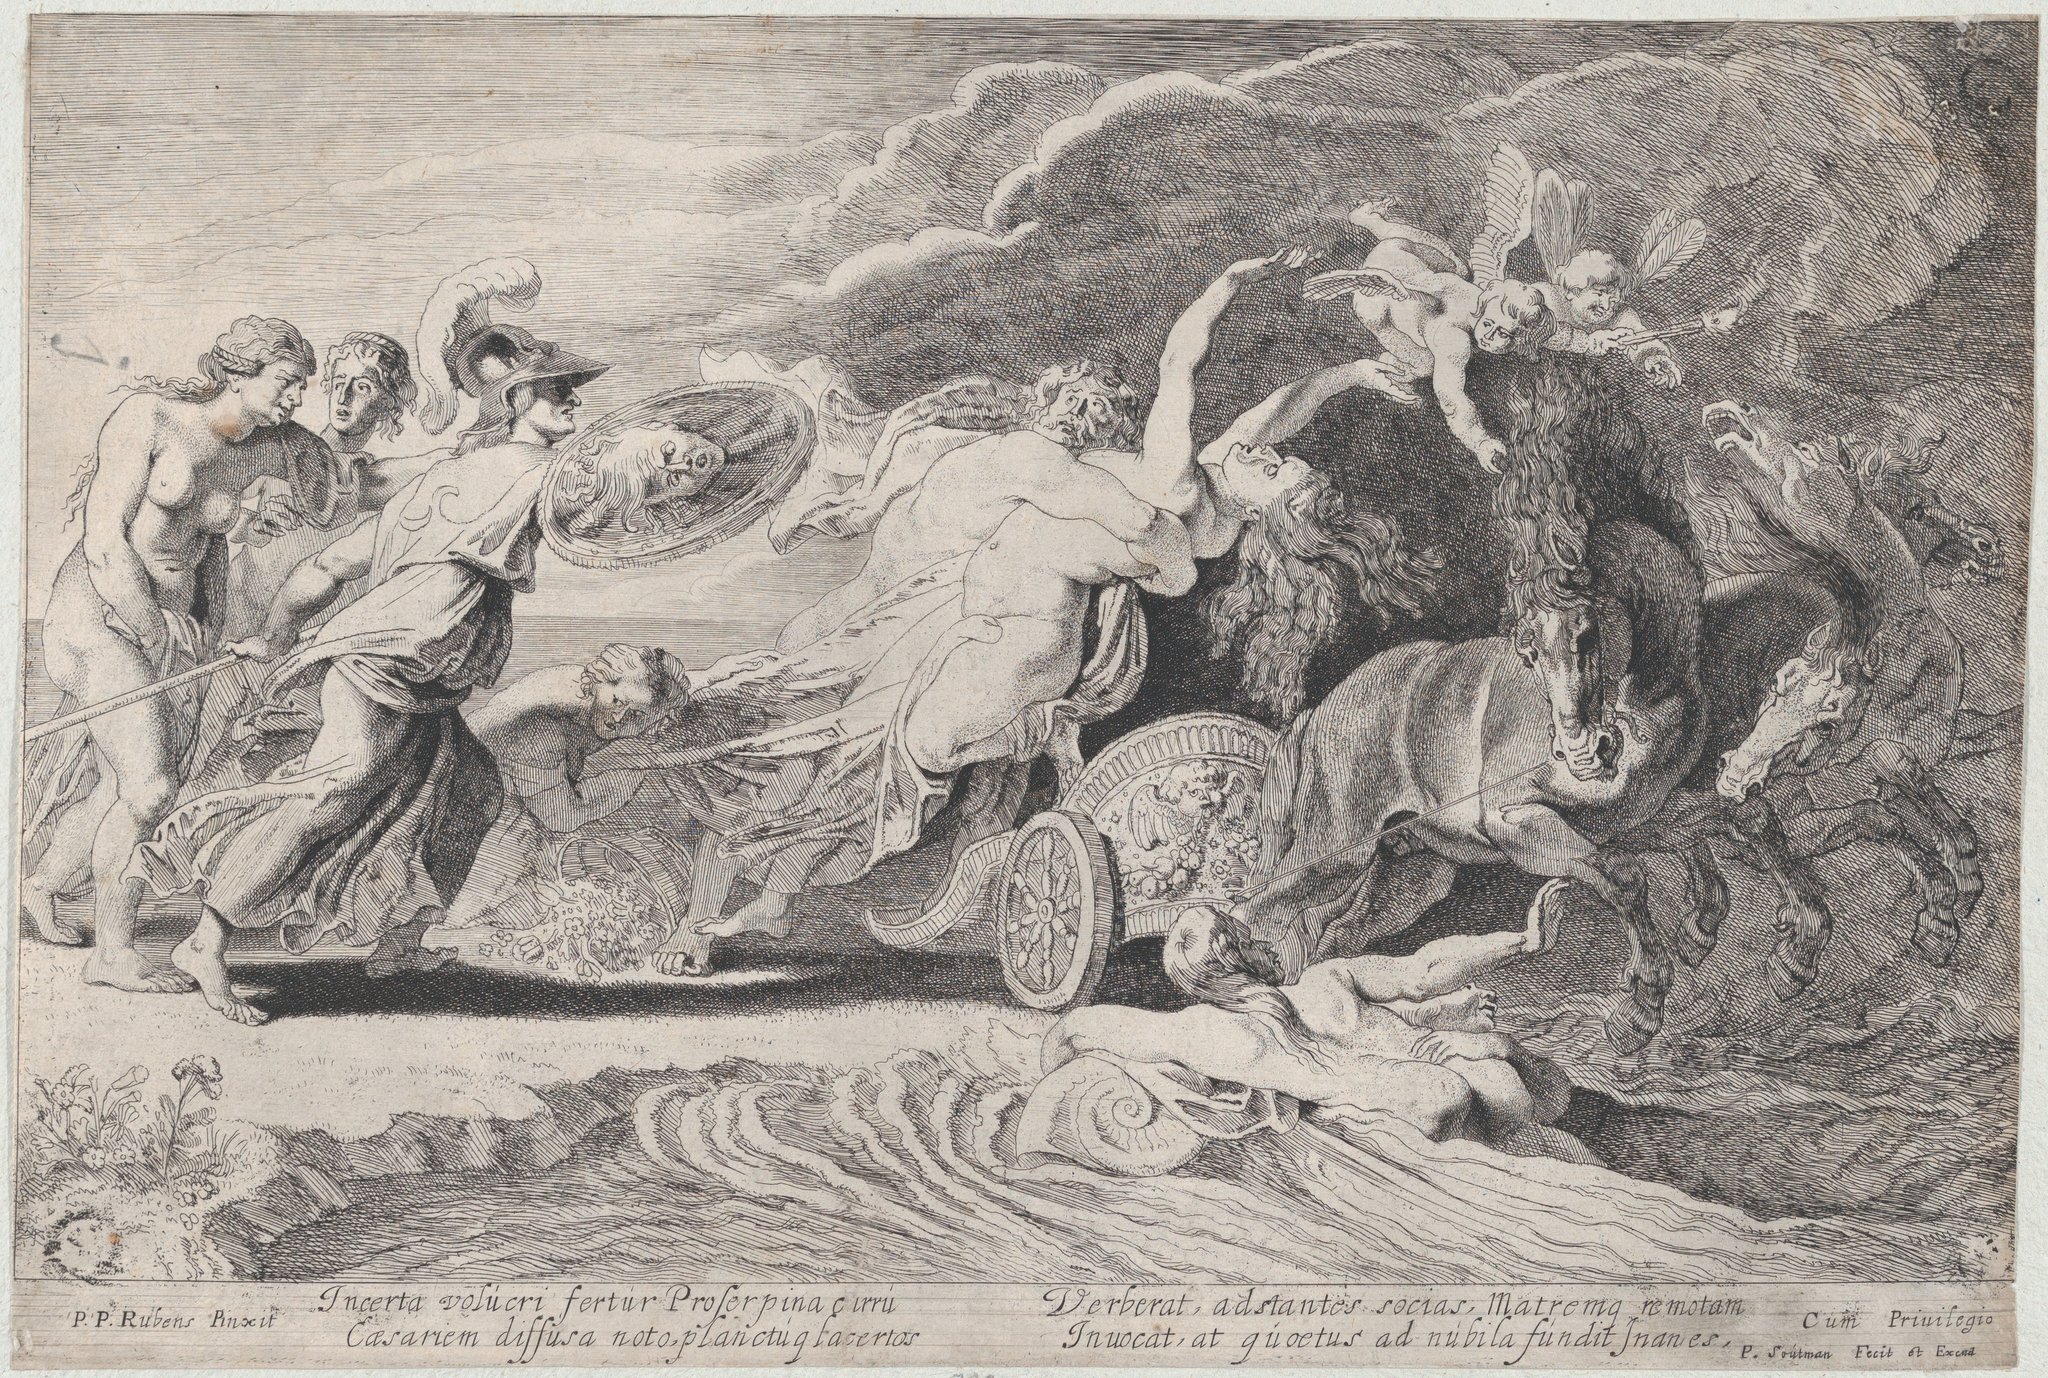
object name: print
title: The Abduction of Proserpina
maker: pieter soutman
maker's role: artist and publisher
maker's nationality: dutch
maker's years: 1580-1657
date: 1620-1625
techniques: etching